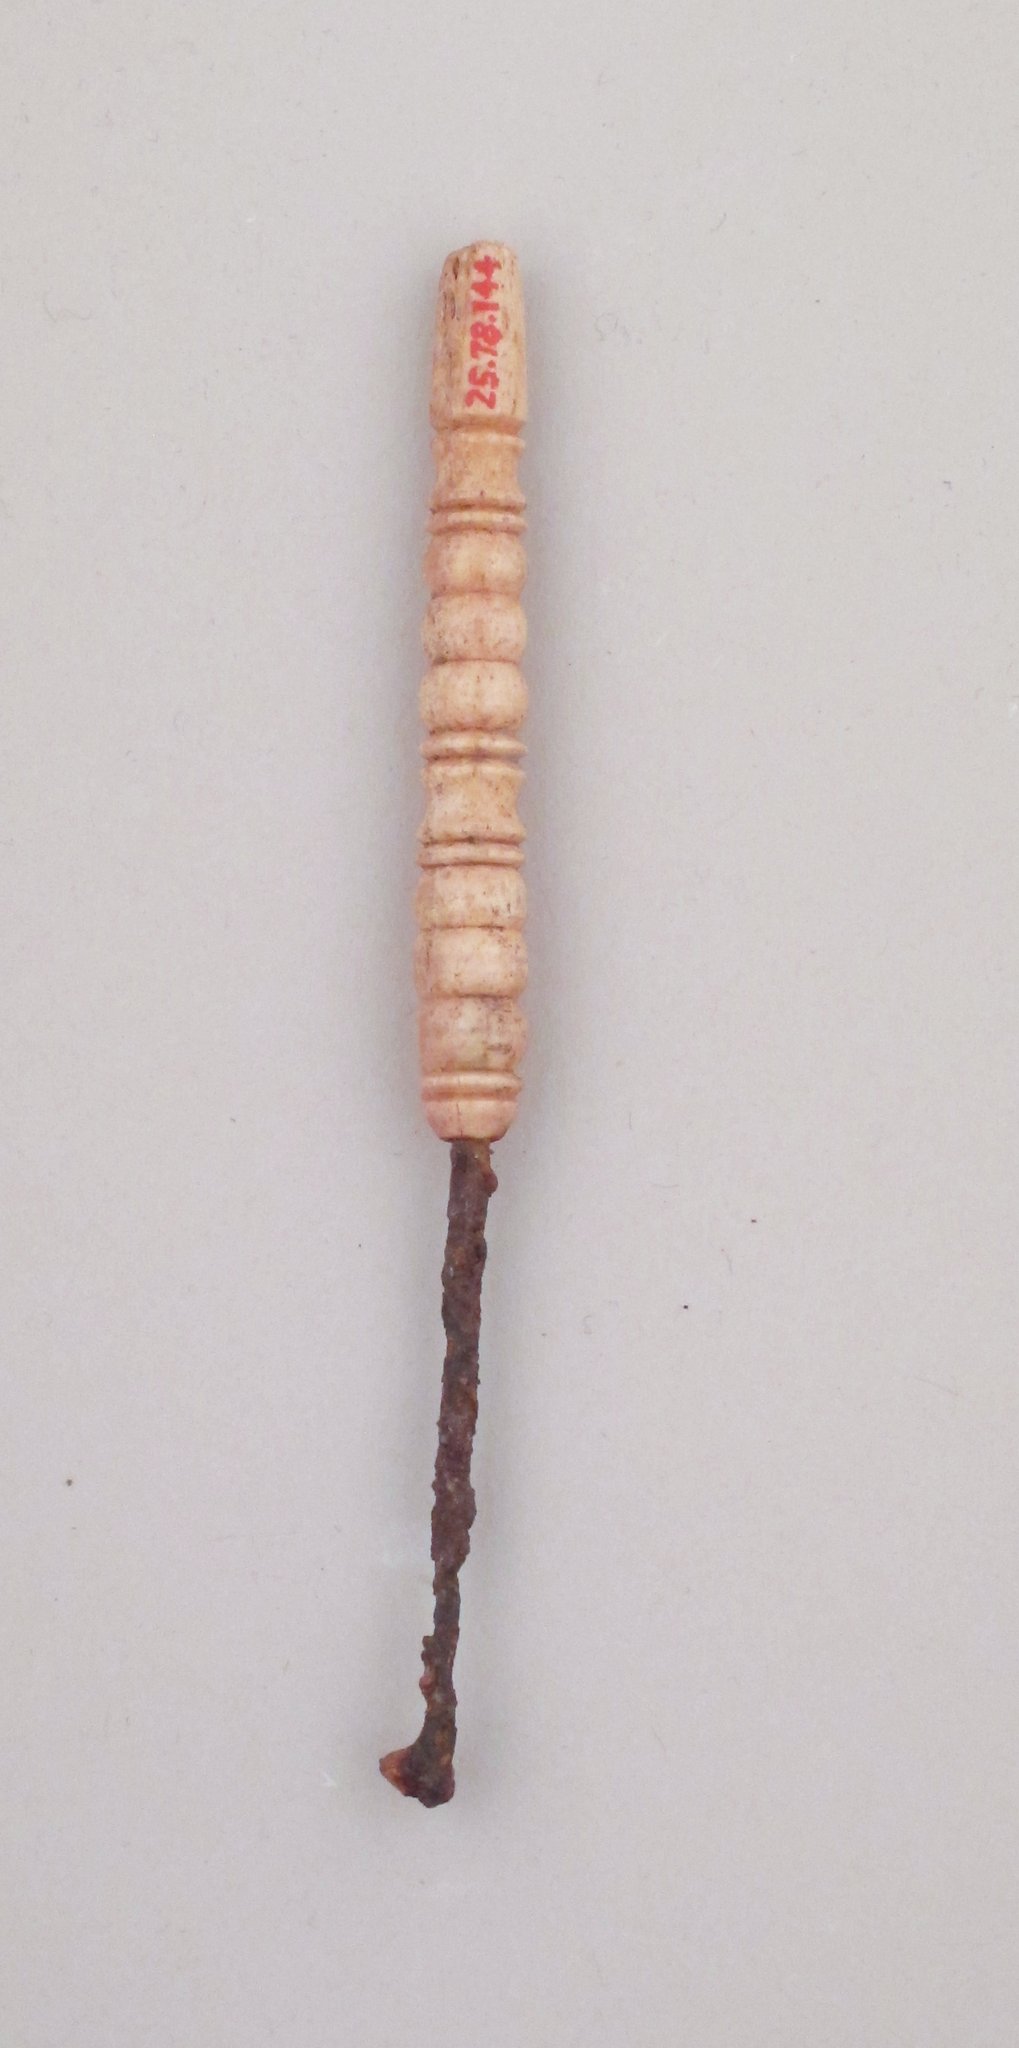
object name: needle with ivory handle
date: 7000 BCE-330 CE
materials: iron, ivory